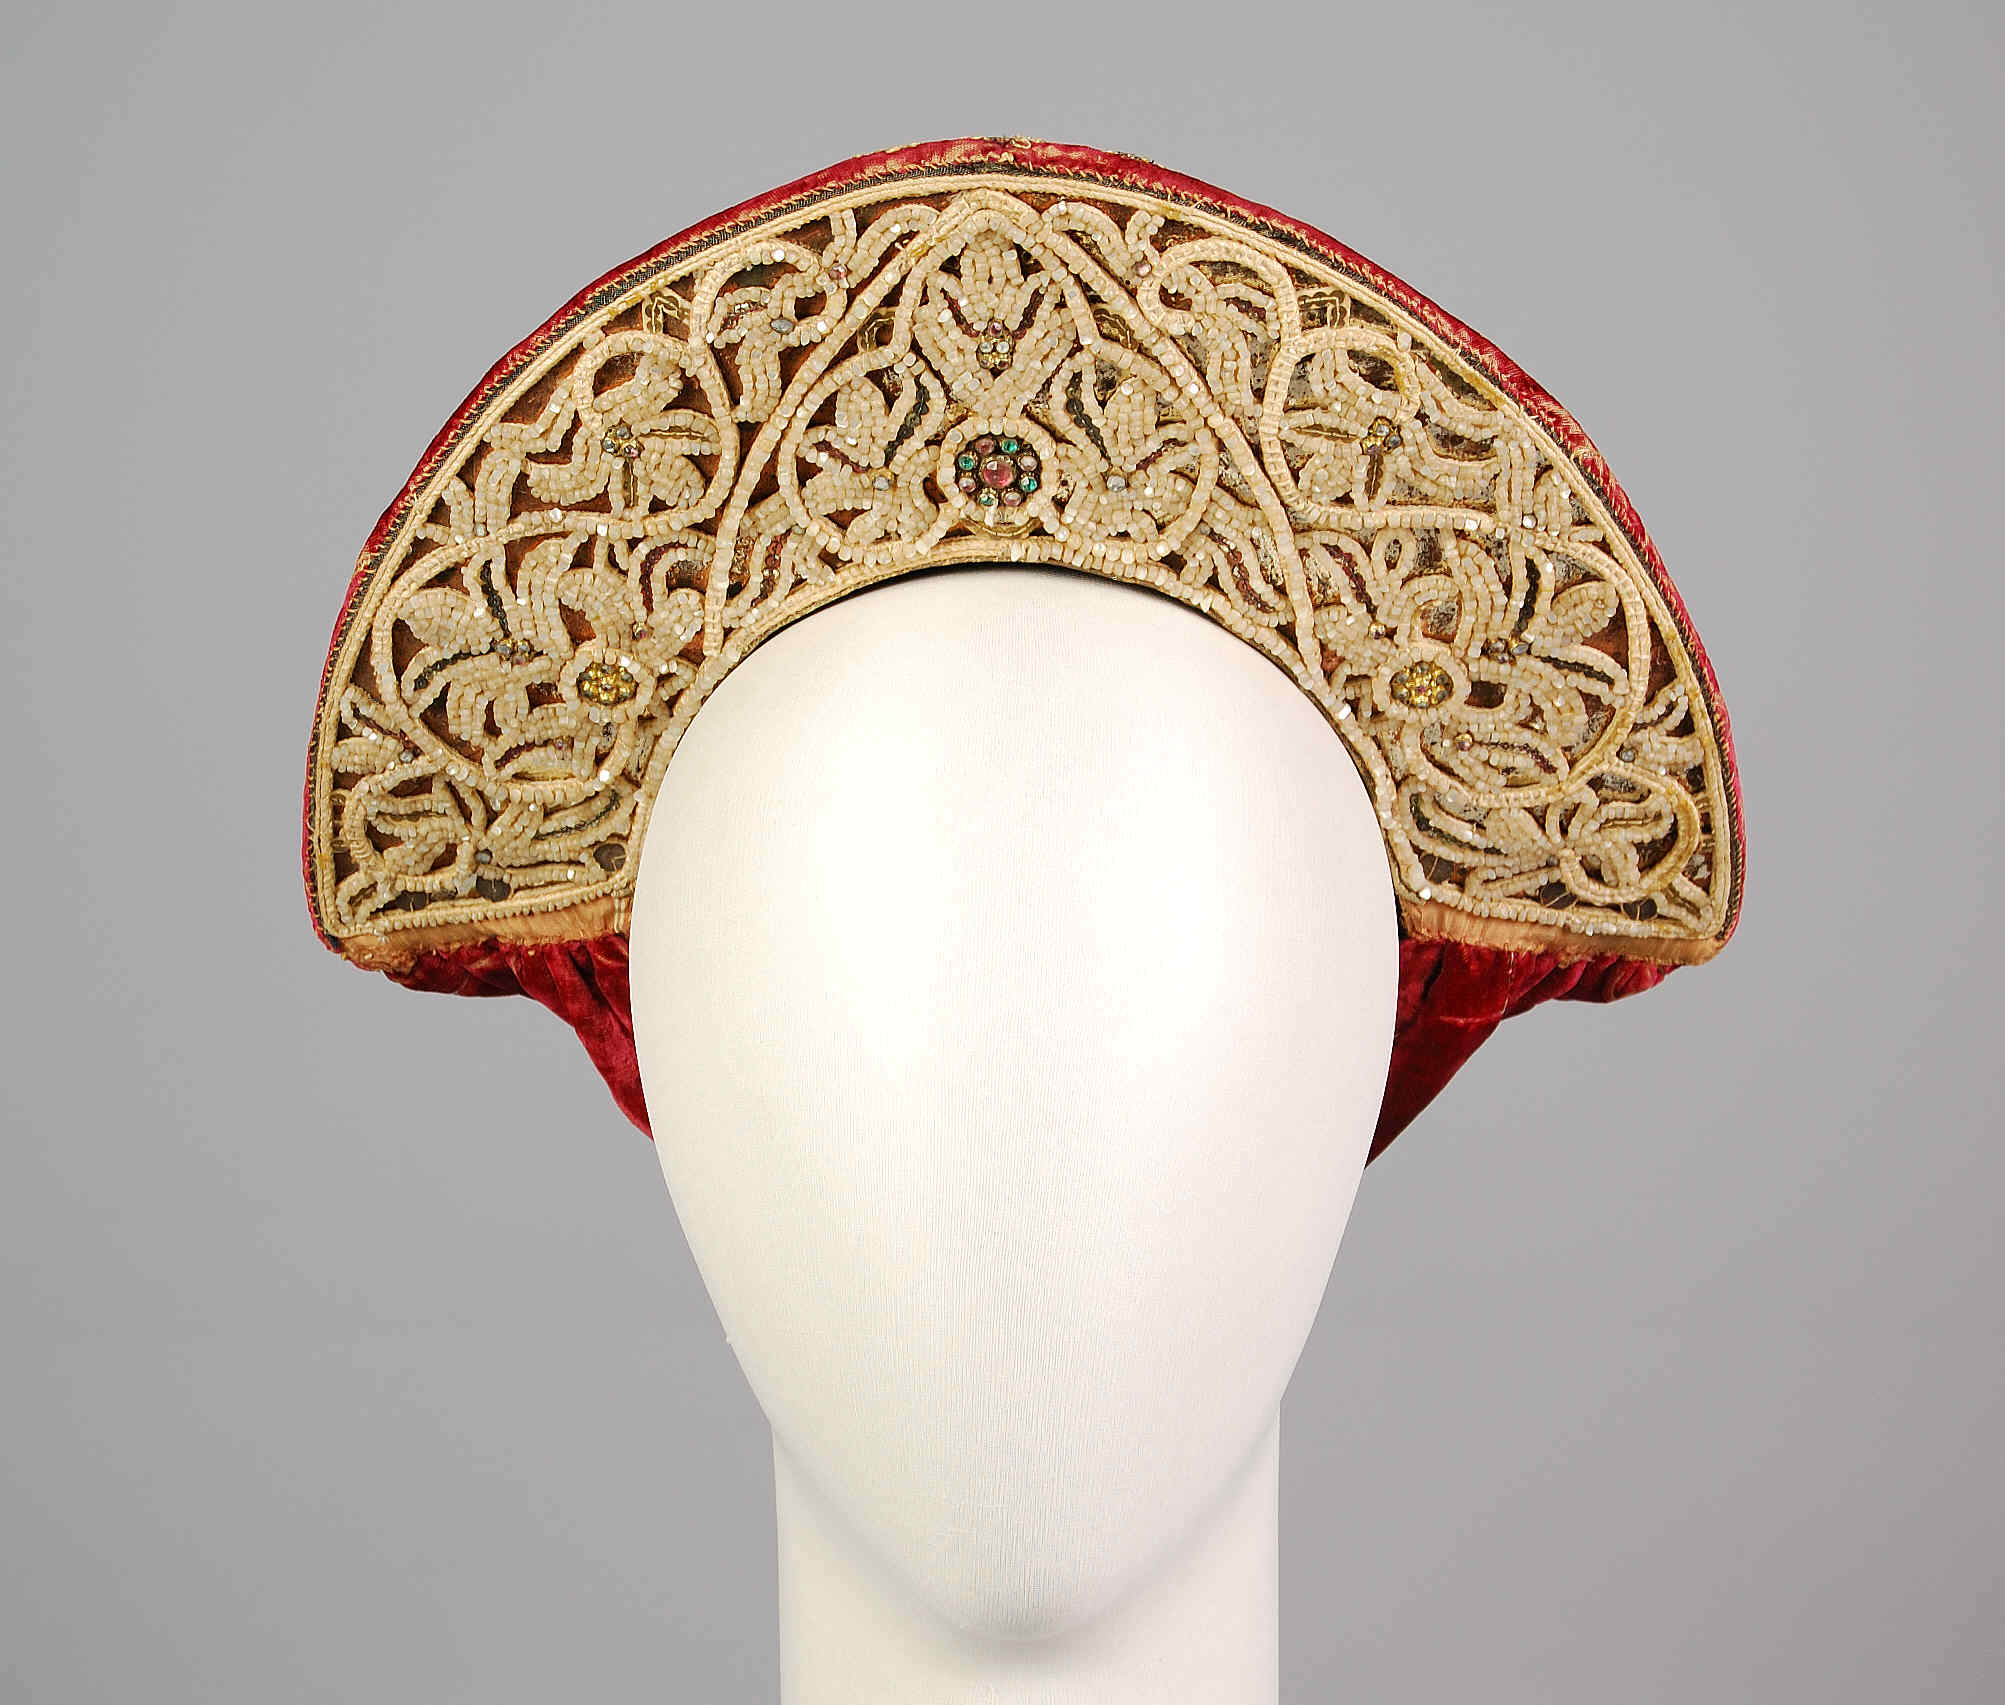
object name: headdress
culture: russian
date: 1800-1850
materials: cotton, glass, metal, shell, silk